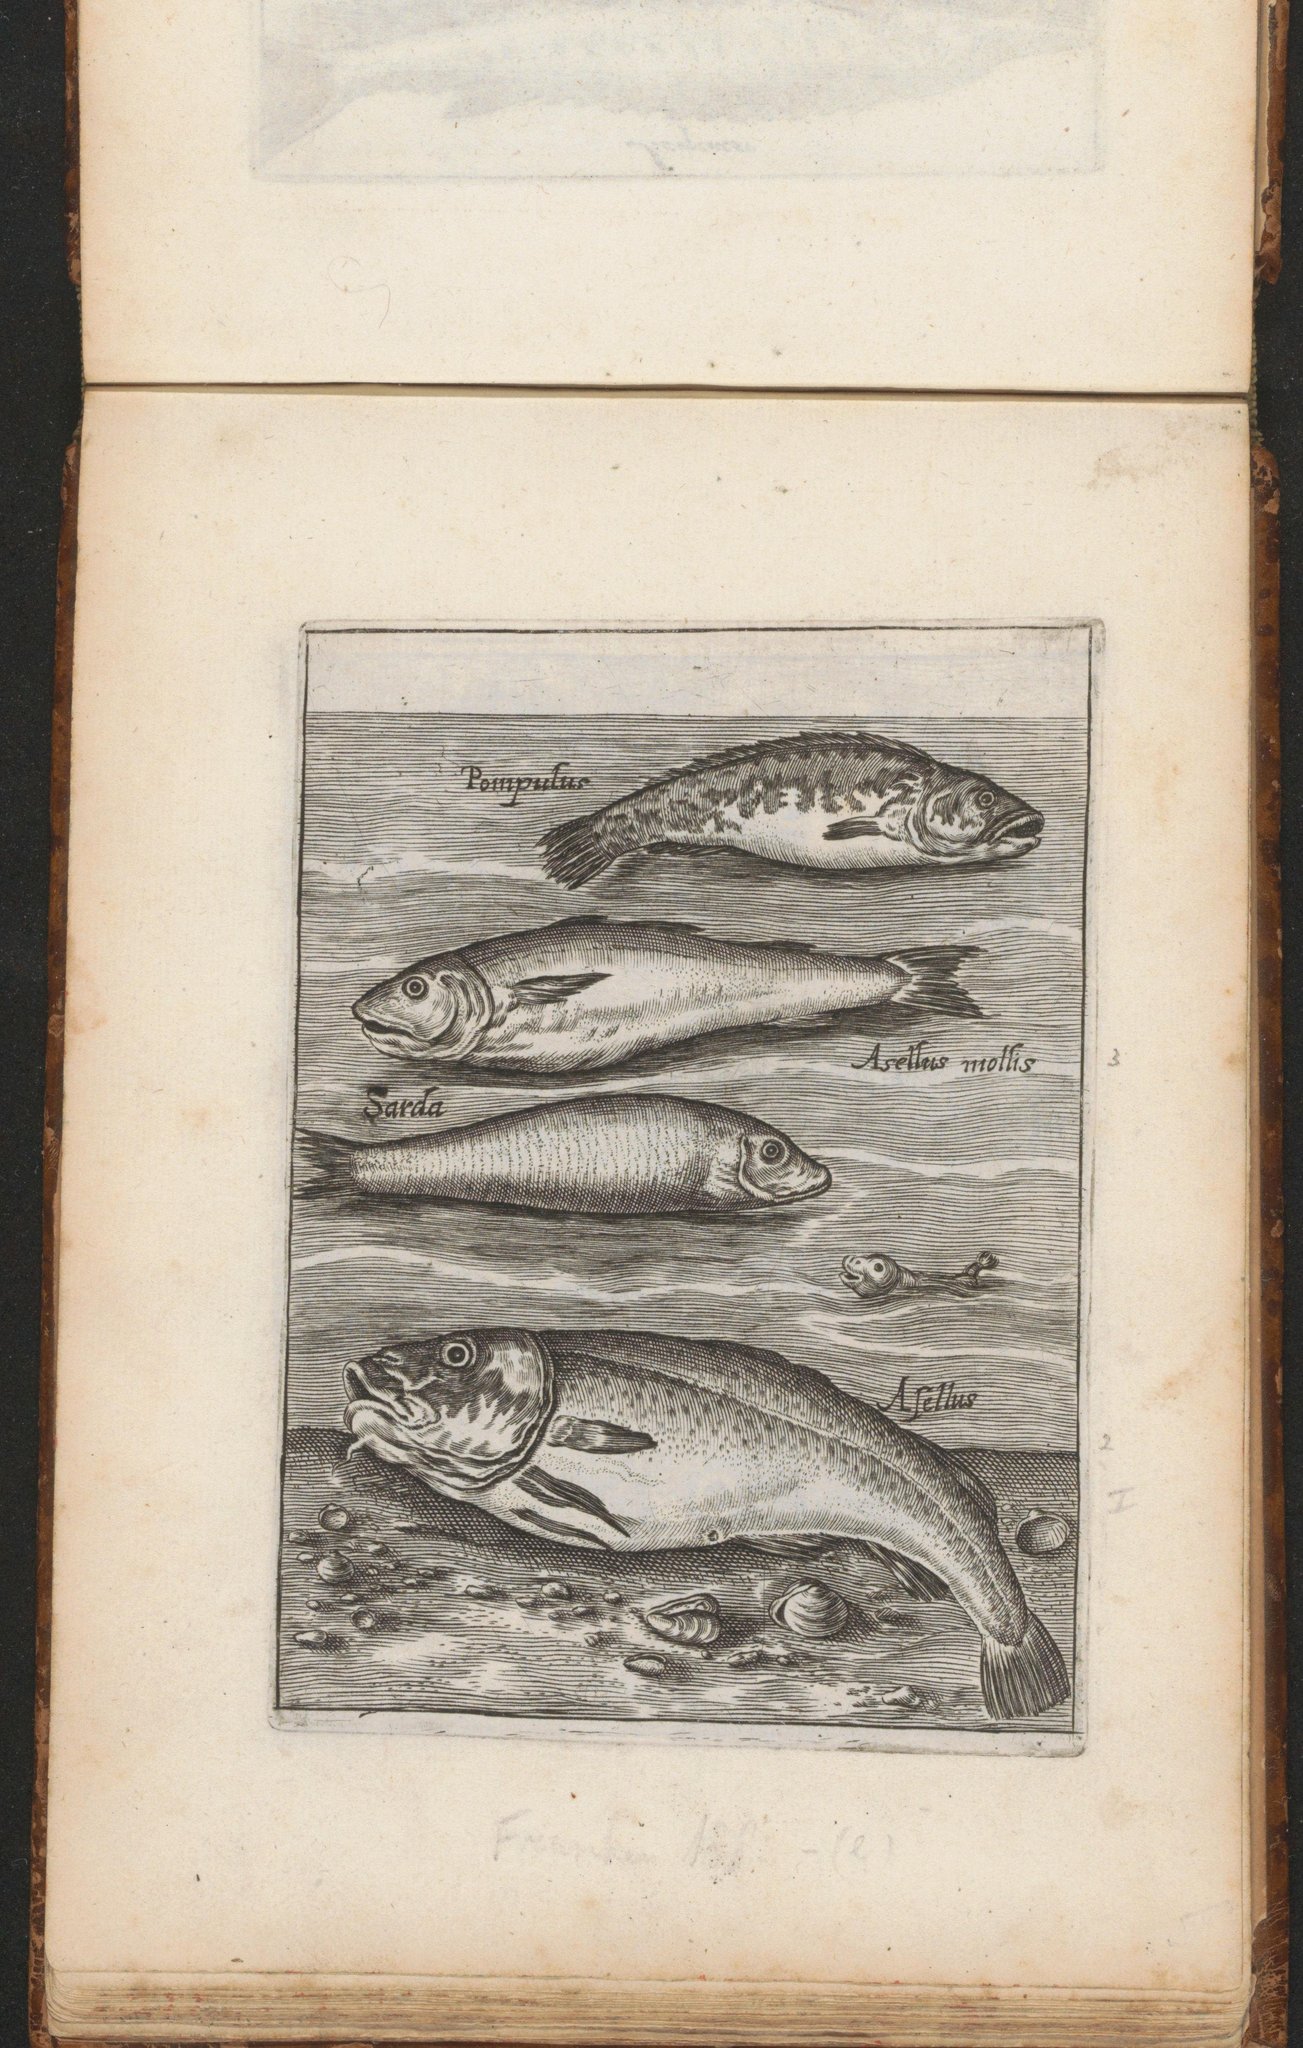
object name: album leaf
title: Vissen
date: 1635-1660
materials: paper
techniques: engraving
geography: utrecht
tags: fishes, bony fishes: cod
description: Vier vissen. Van boven naar beneden een loodsmannetje, wijting, sarda en kabeljauw. Bij iedere vis de naam in het Latijn. Deze prent maakt deel uit van een album.